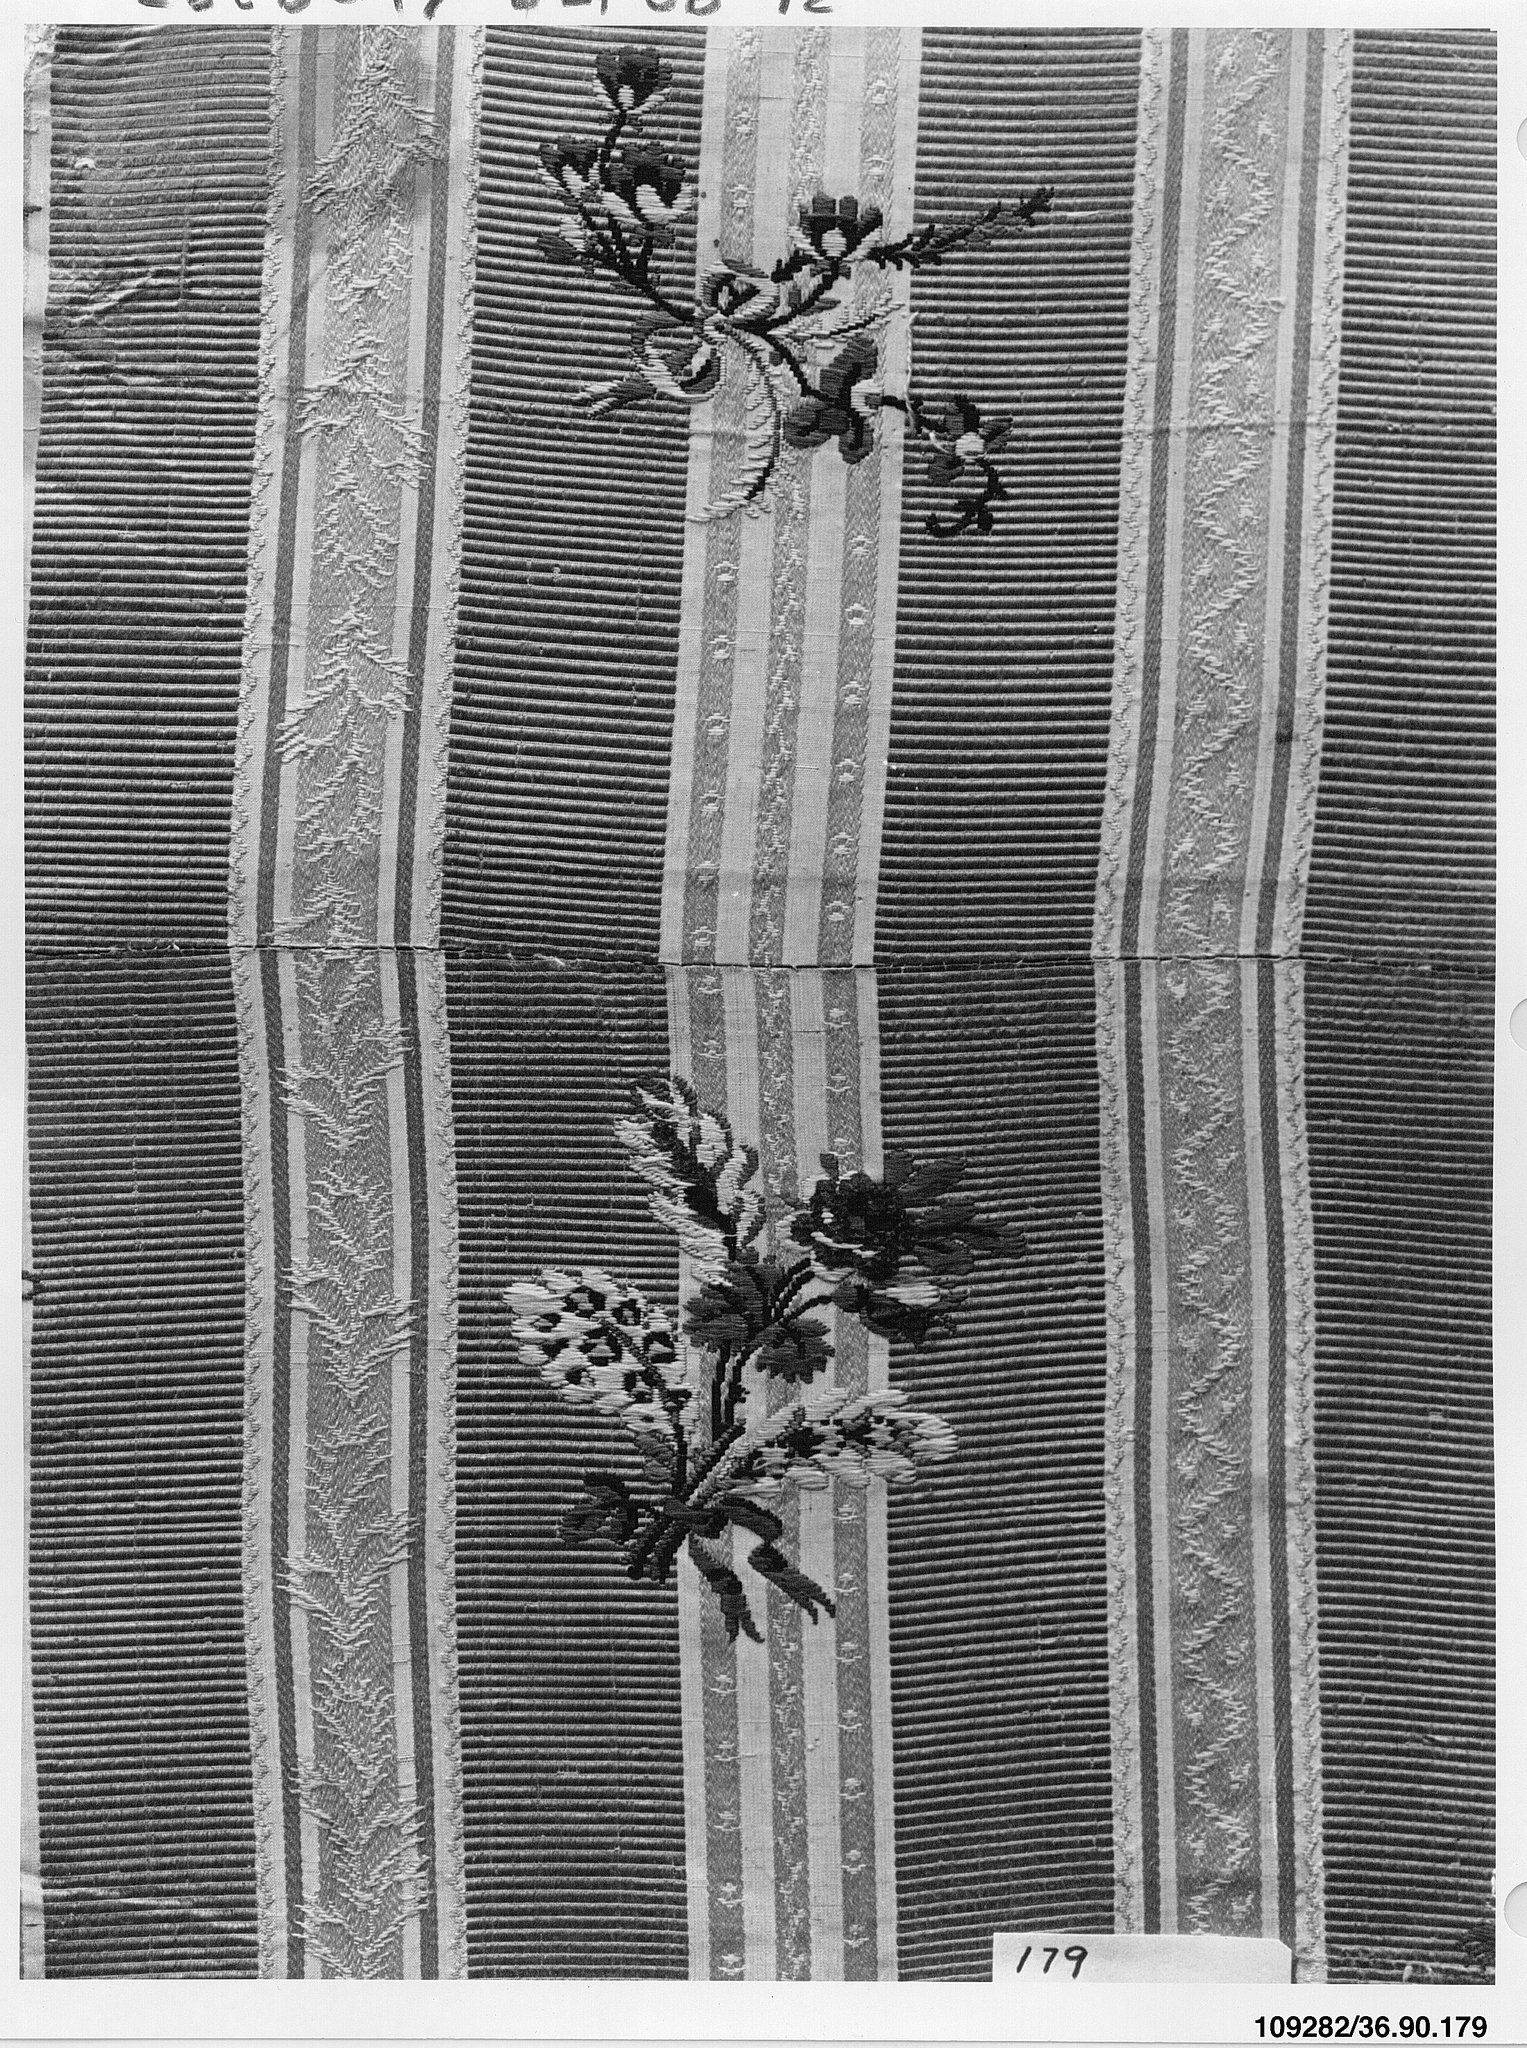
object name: piece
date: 1701-1800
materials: silk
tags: flowers,leaves